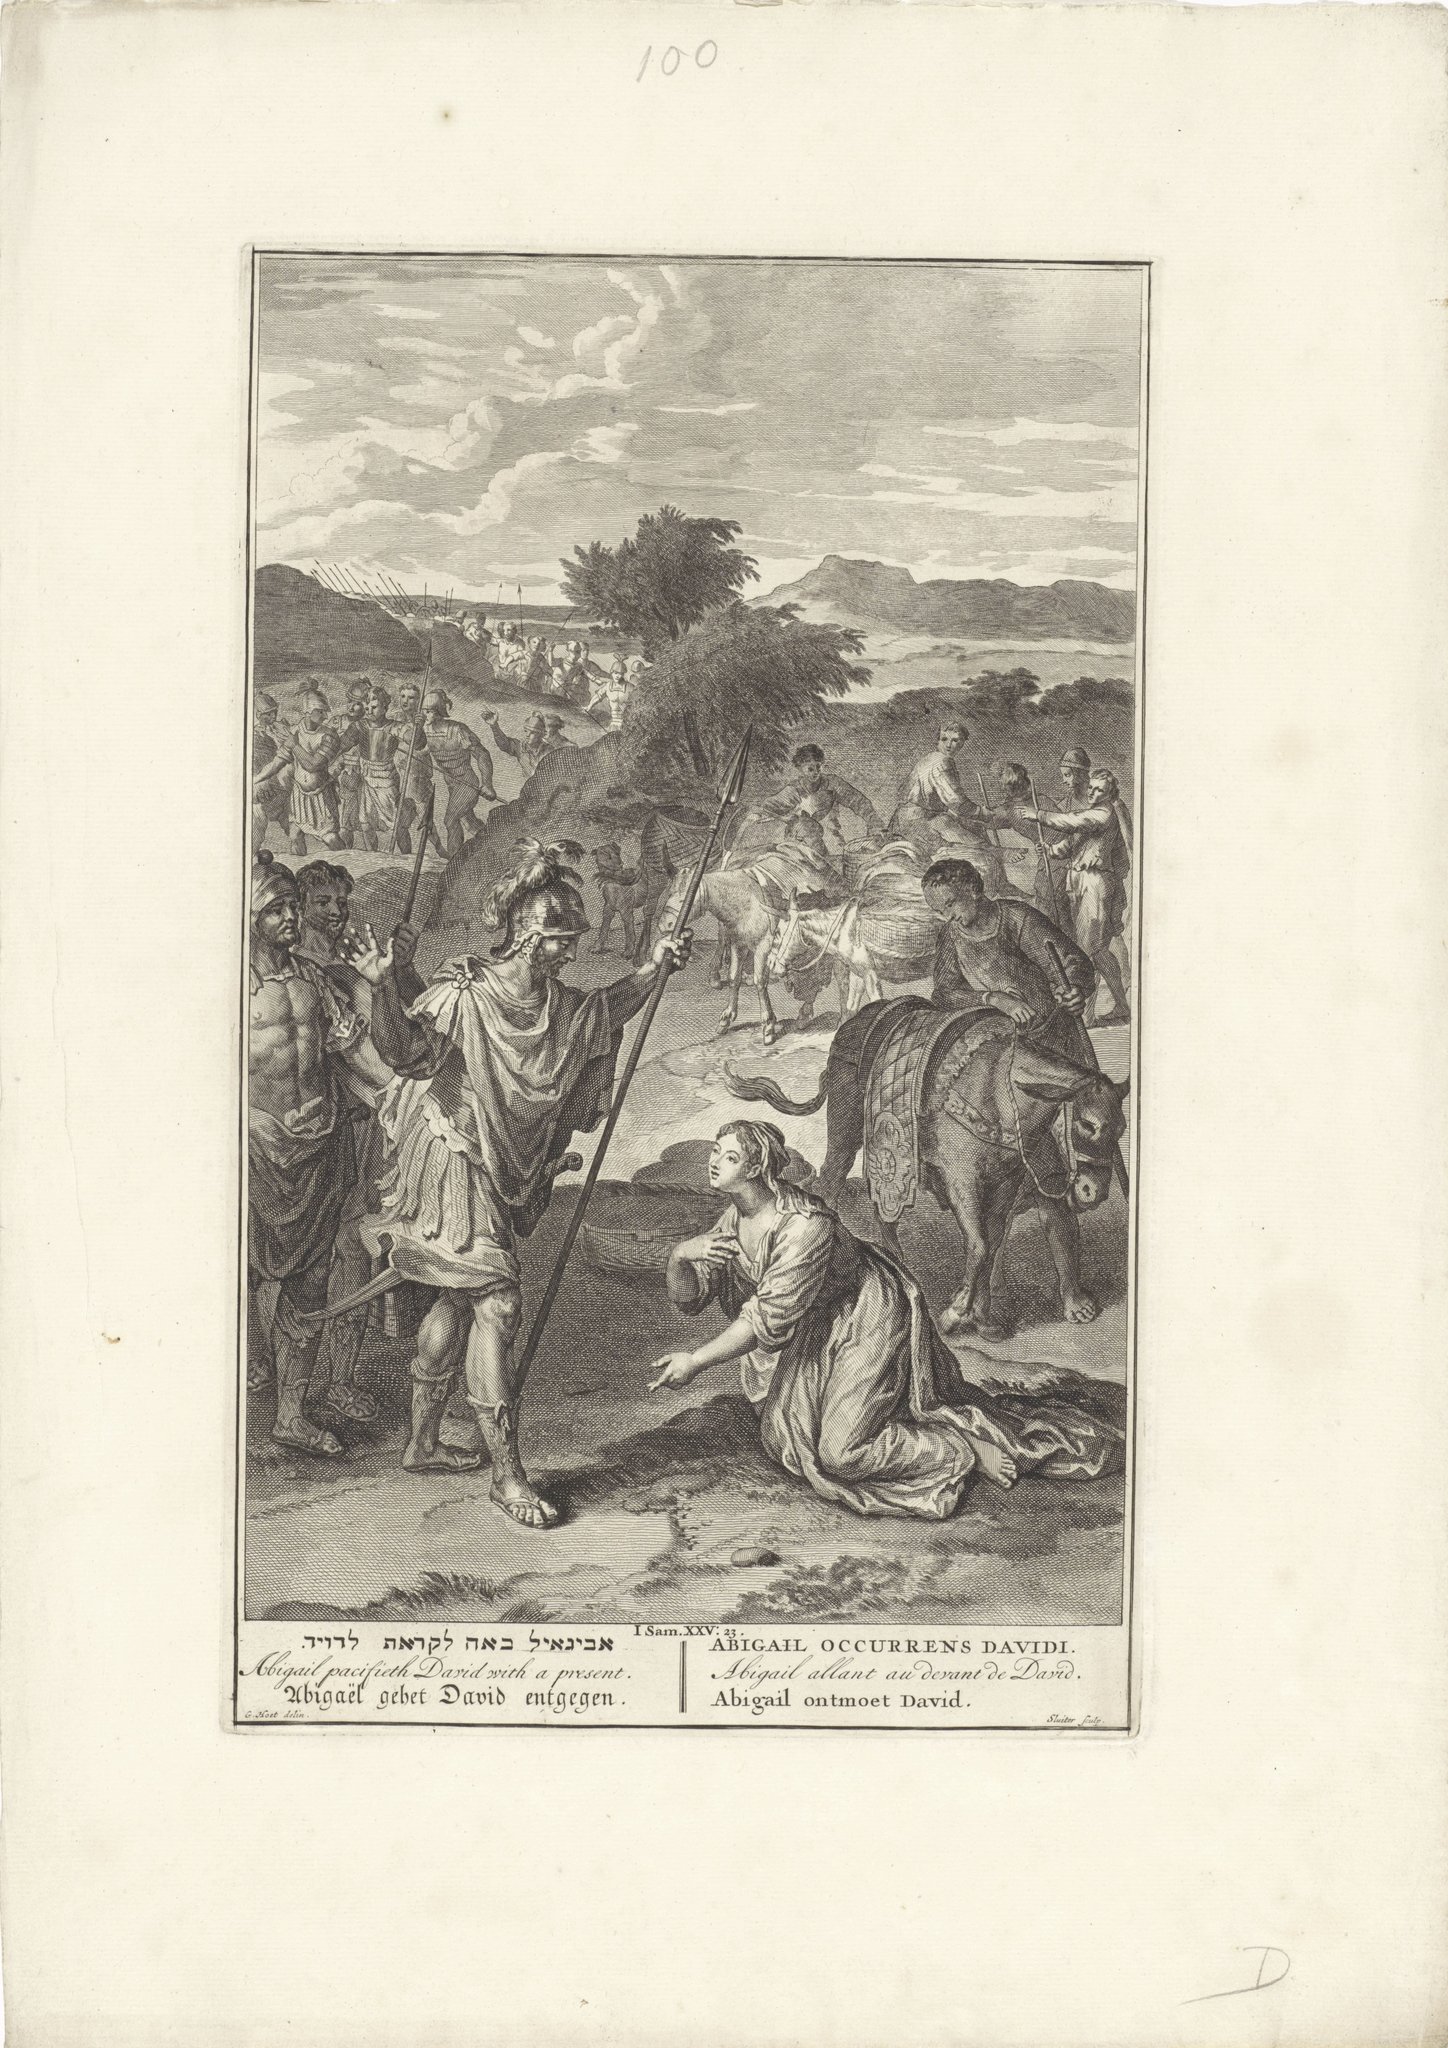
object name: book illustration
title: Abigail ontmoet David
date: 1705-1720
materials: paper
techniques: engraving, etching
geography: amsterdam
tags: meeting of david and abigail, who kneels before him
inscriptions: collector's mark: Lugt 2228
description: David geeft met zijn hand een stopteken aan de stoet soldaten achter hem, wanneer hij Abigail voor hem ziet knielen. Achter haar staat een dienaar met een ezel, met op de achtergrond de rest van haar dienaren met volgepakte ezels. Illustratie van de Bijbeltekst 1 Sam. 25:23. Onder de voorstelling de titel in het Hebreeuws, Engels, Duits, Latijn, Frans en Nederlands.